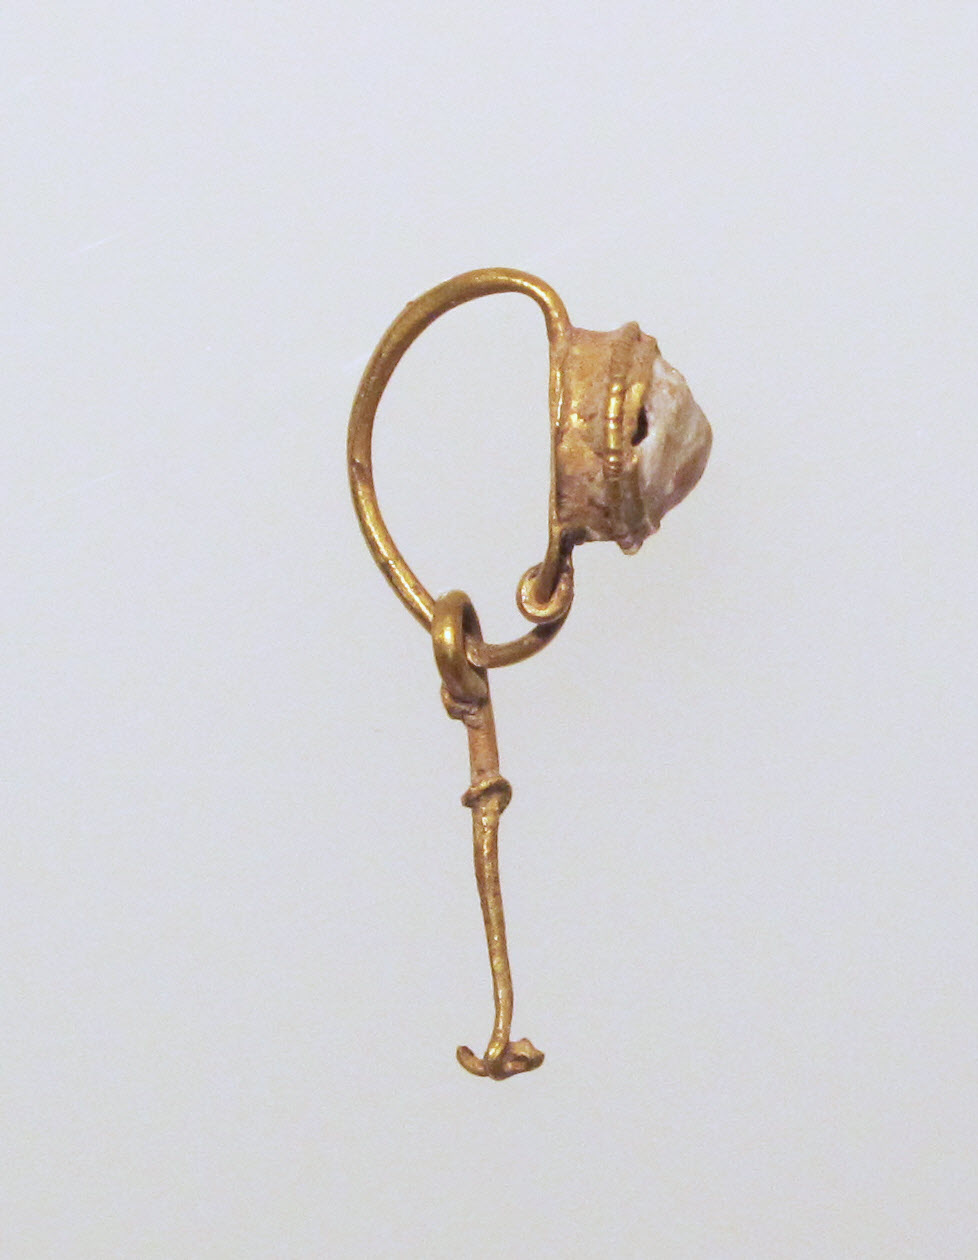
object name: earring with pendant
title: Gold earring with pearl setting and pendant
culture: roman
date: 670 BCE-330 CE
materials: gold